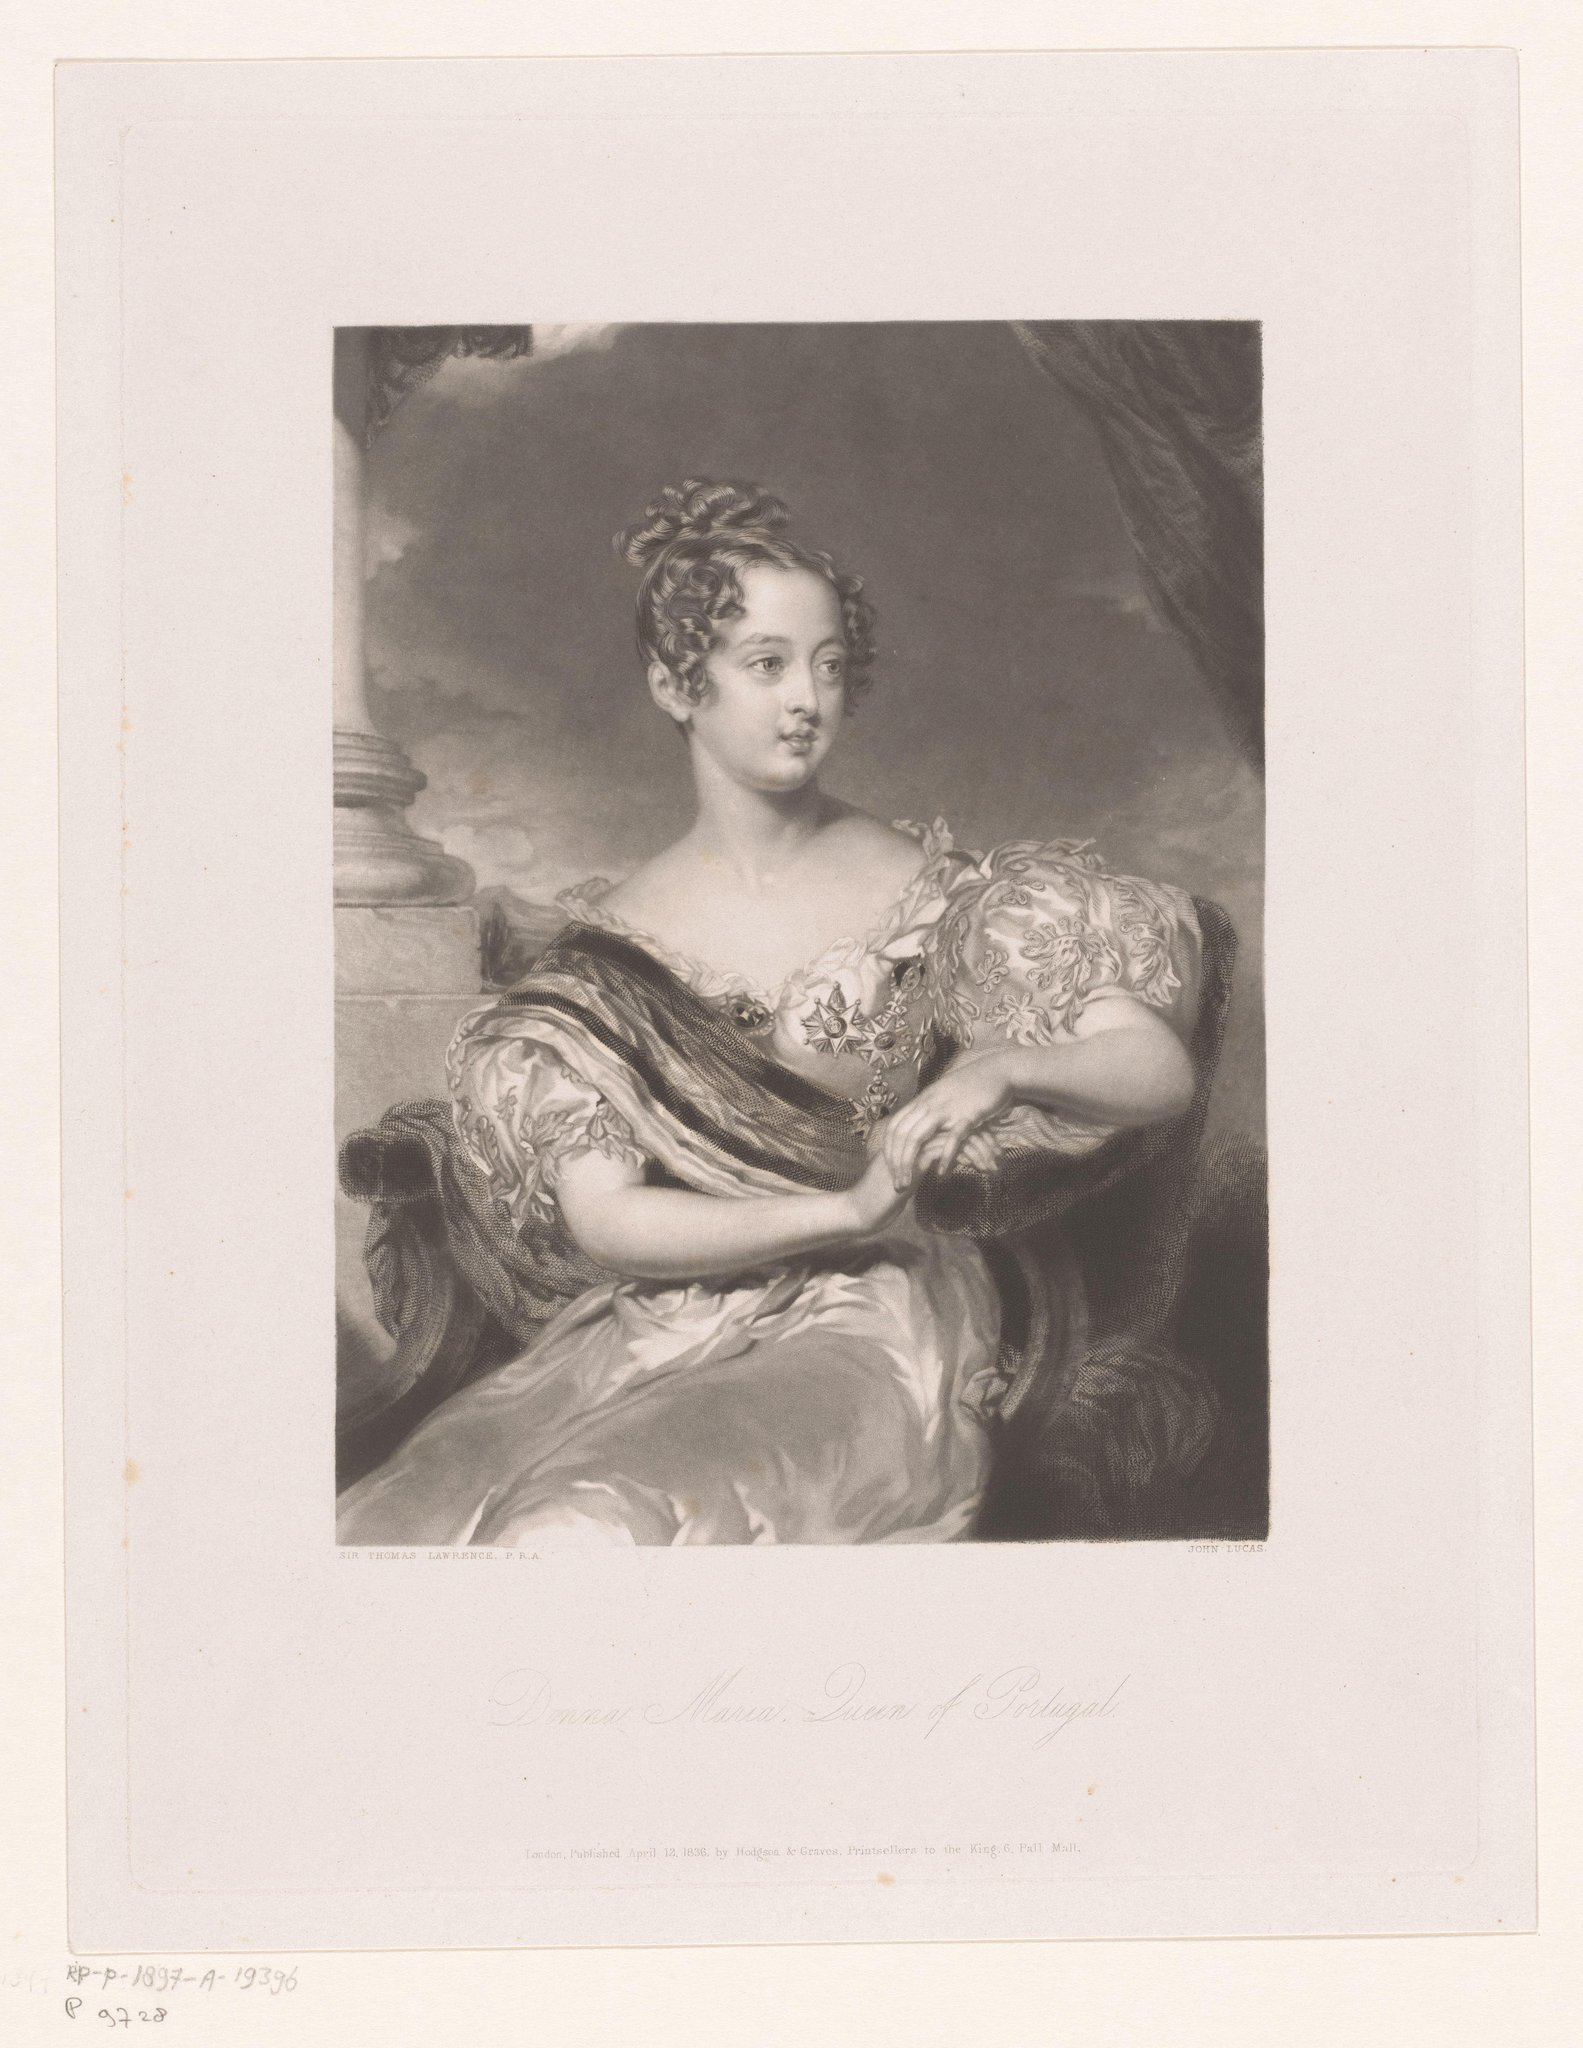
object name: print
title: Donna Maria Queen of Portugal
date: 1836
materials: paper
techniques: etching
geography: london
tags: historical persons, queen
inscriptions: collector's mark: Lugt 2228